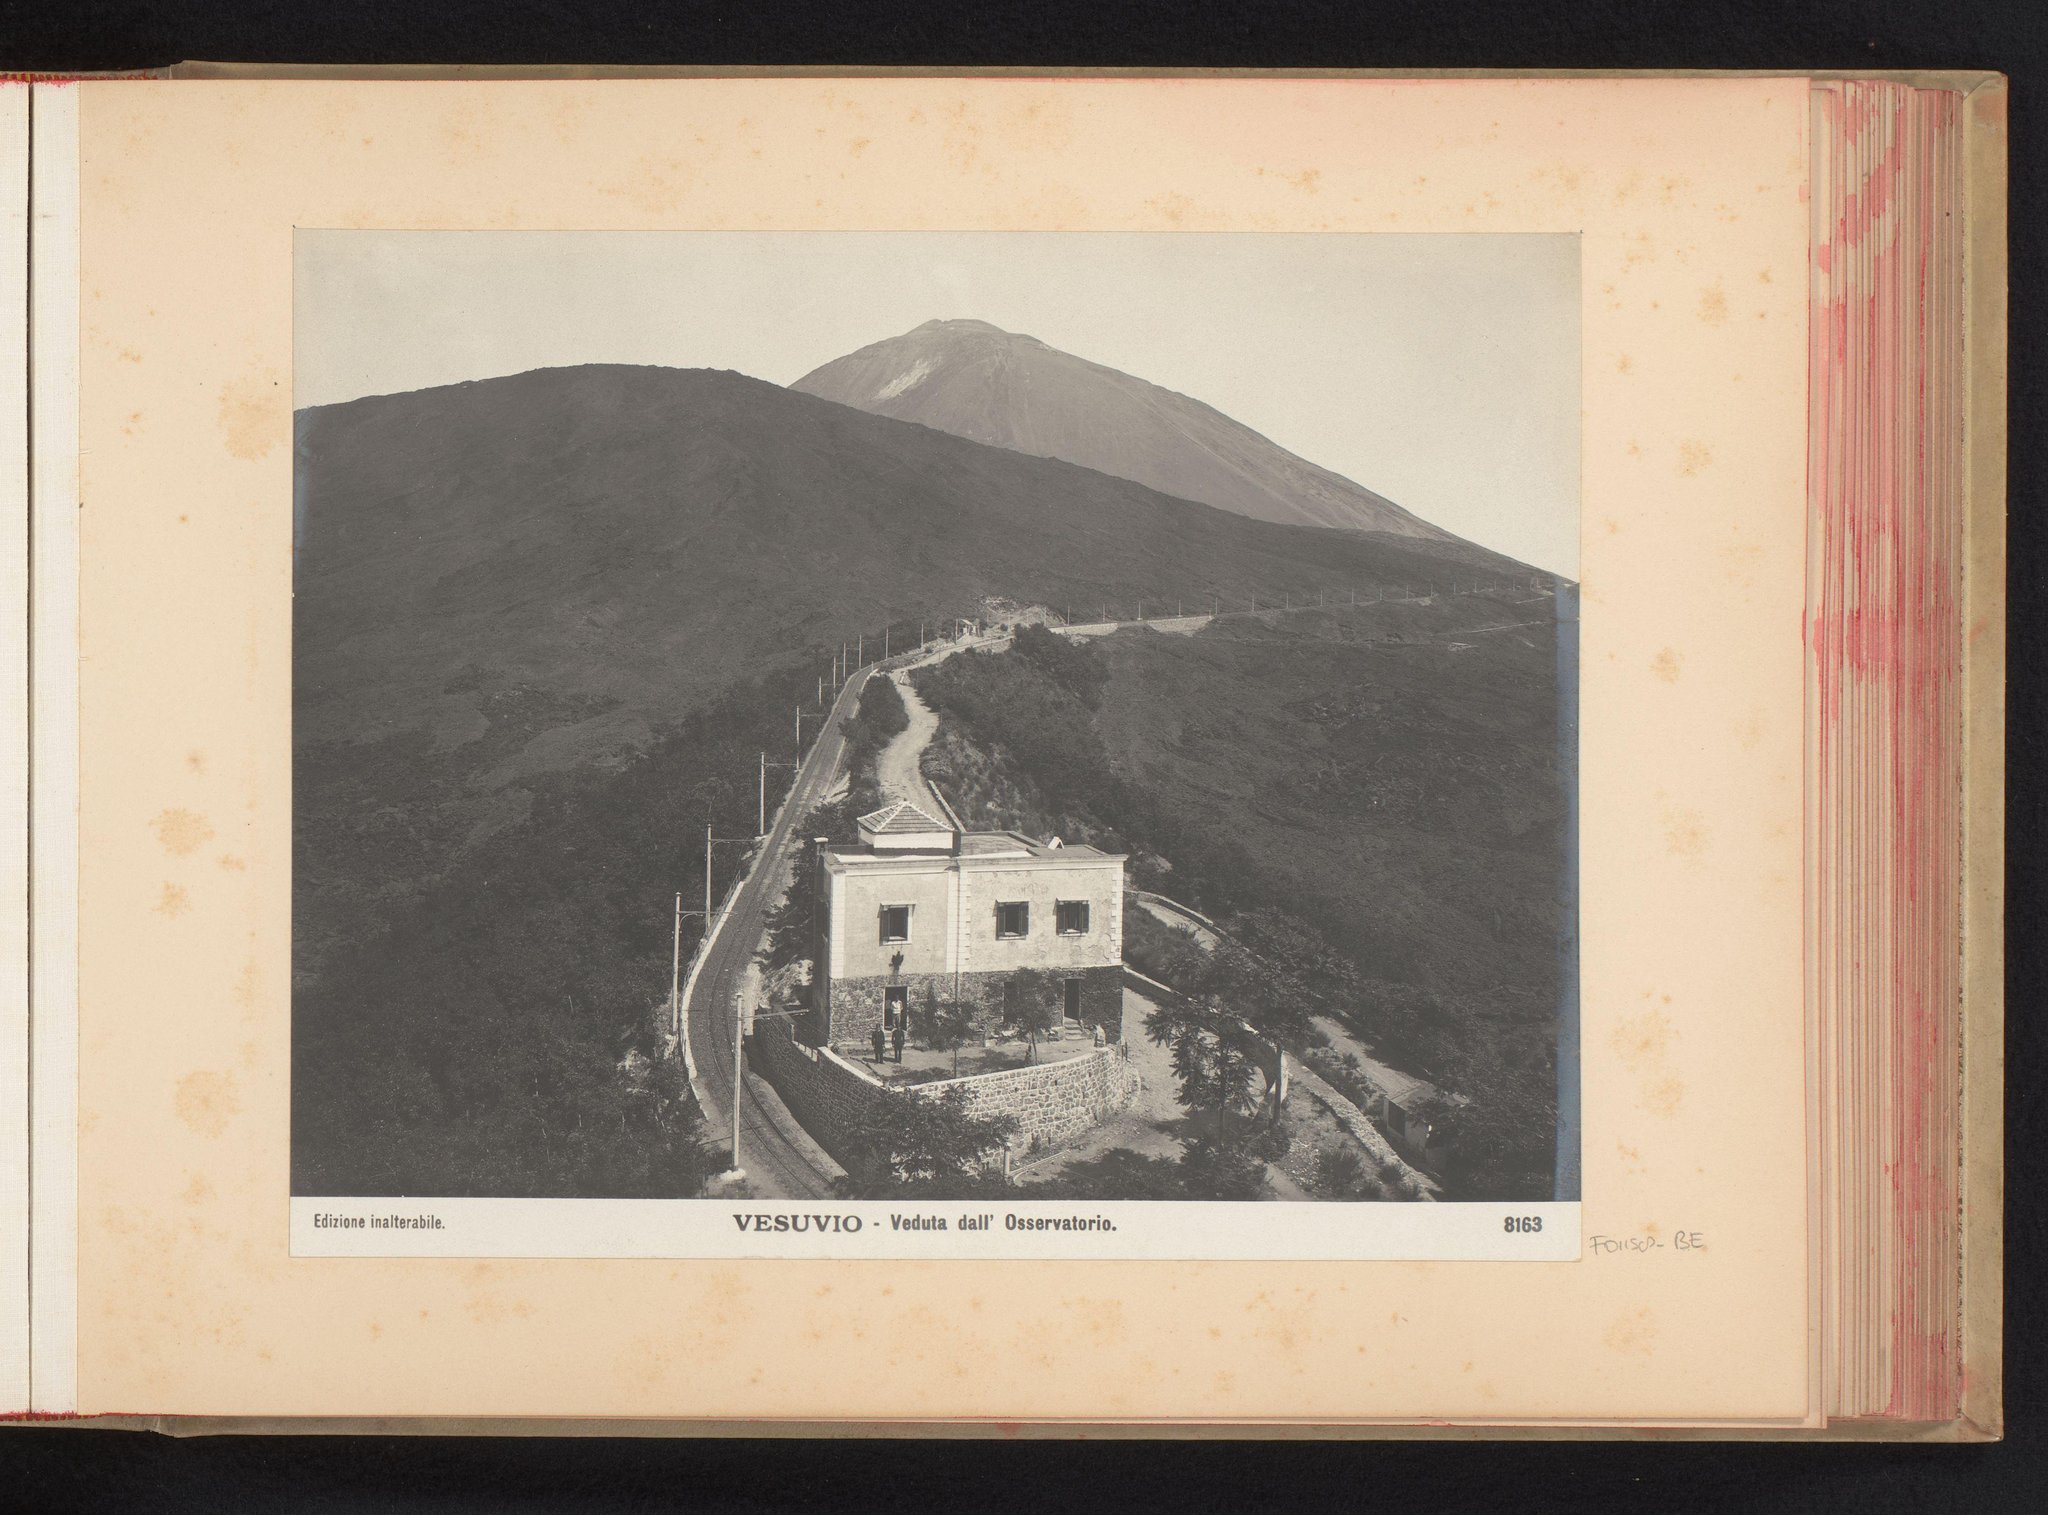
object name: photograph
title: Vesuvio - Veduta dall' Osservatorio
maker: Anonymous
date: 1875-1907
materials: photographic support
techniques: gelatin silver print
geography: italy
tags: volcano, mount vesuvius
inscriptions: number: ‘8163’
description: Onderdeel van Fotoalbum met opnames van bezienswaardigheden en kunstwerken in Italië.